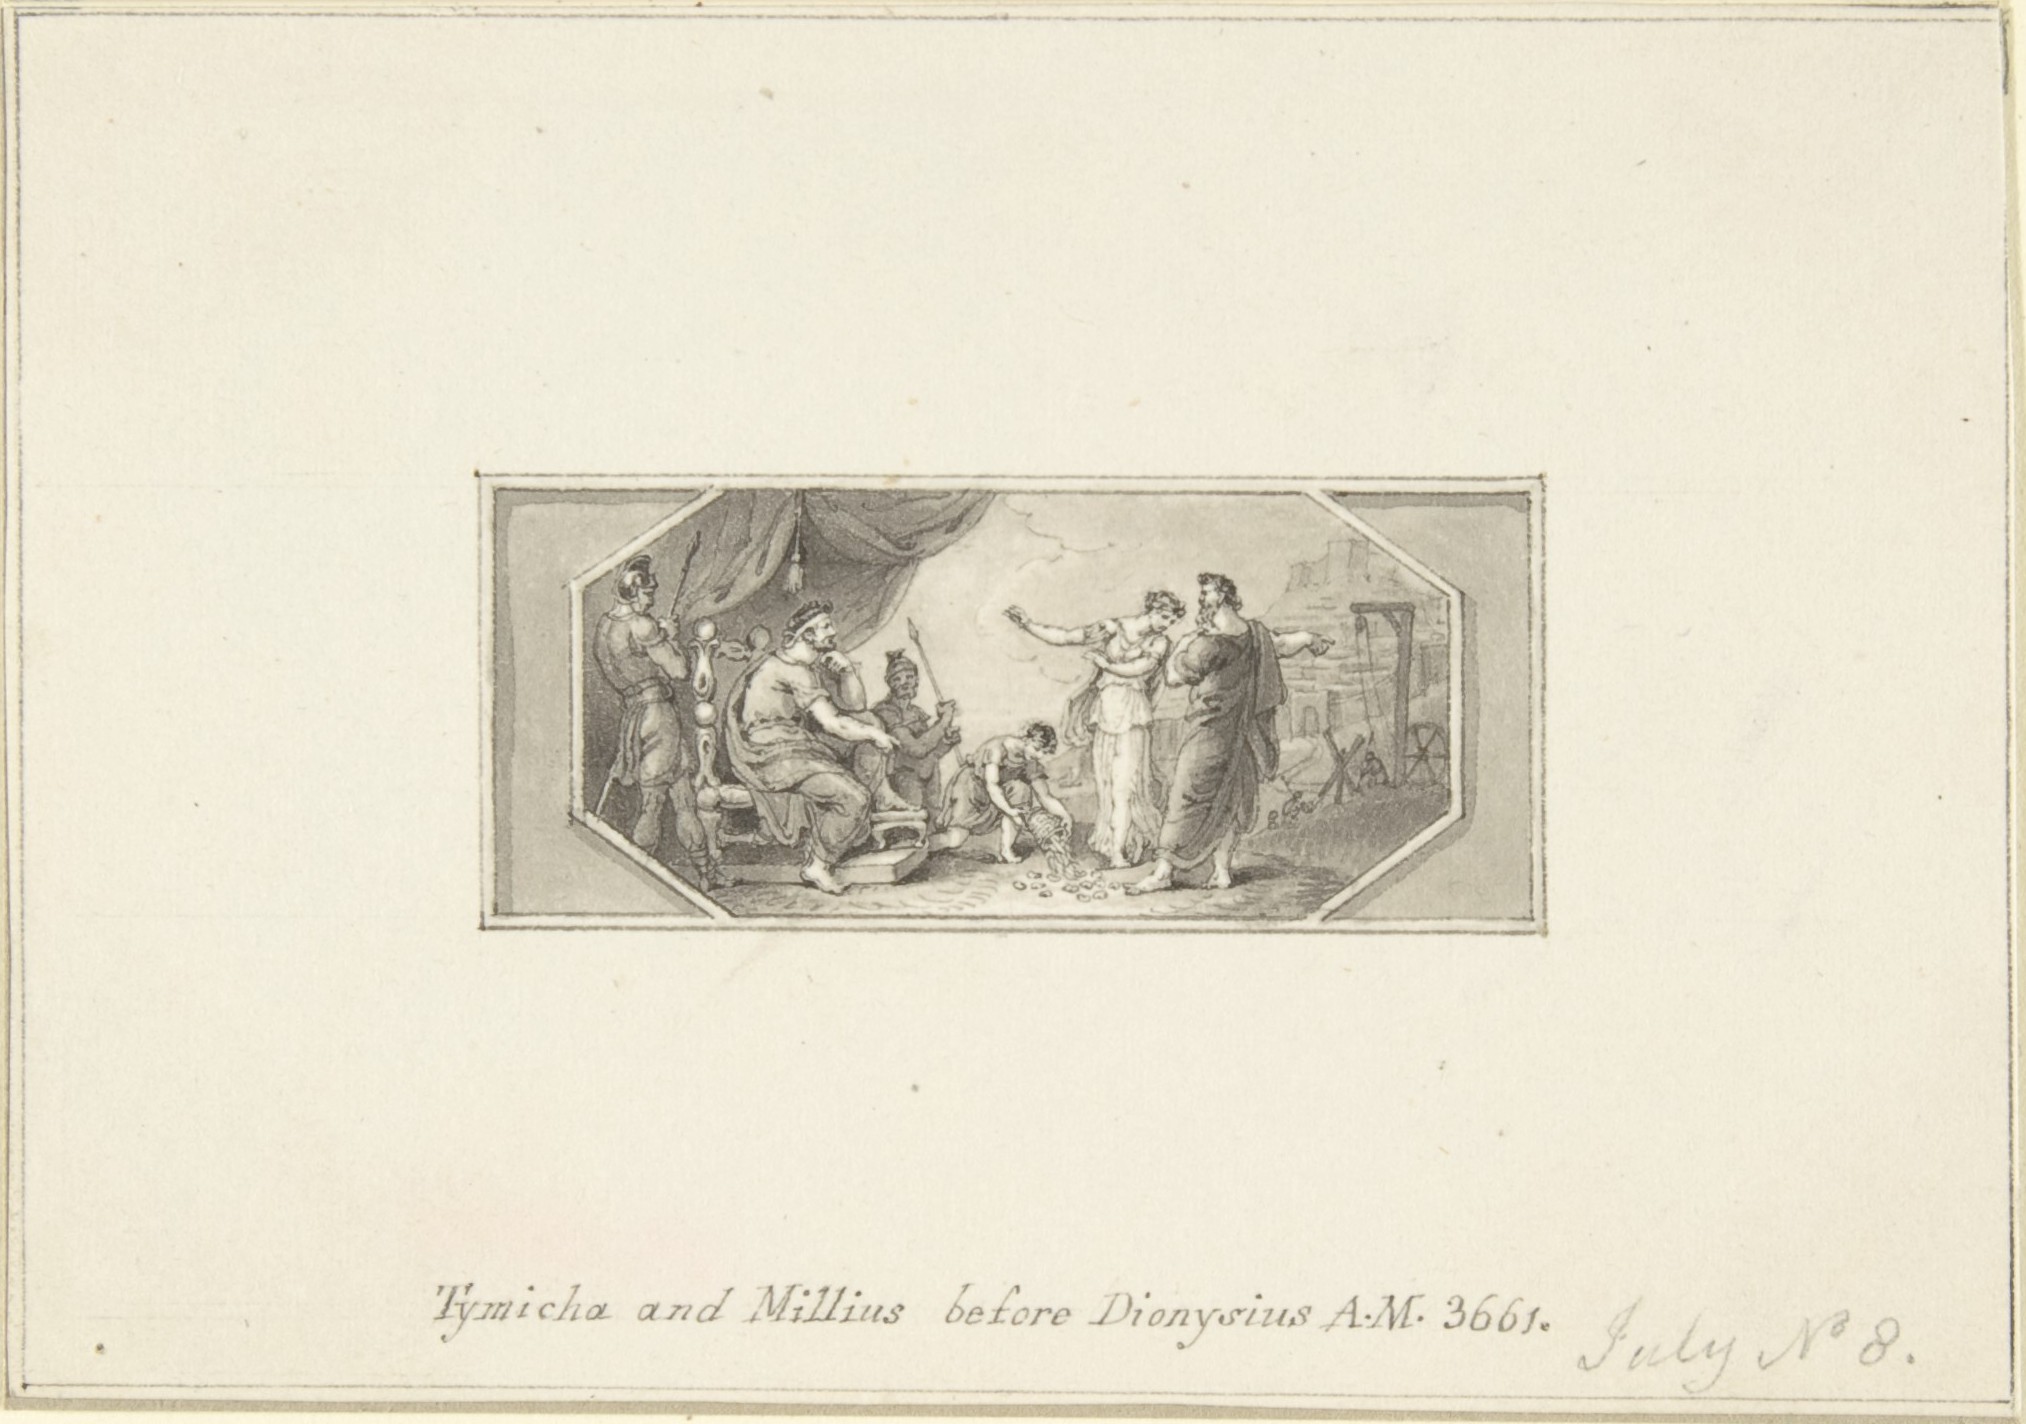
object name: drawing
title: Tymicha and Millius before Dionysius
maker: edward francis burney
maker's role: artist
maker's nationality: british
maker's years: 1760-1848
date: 1790-1800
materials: ink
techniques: brush, pen, wash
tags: men,women